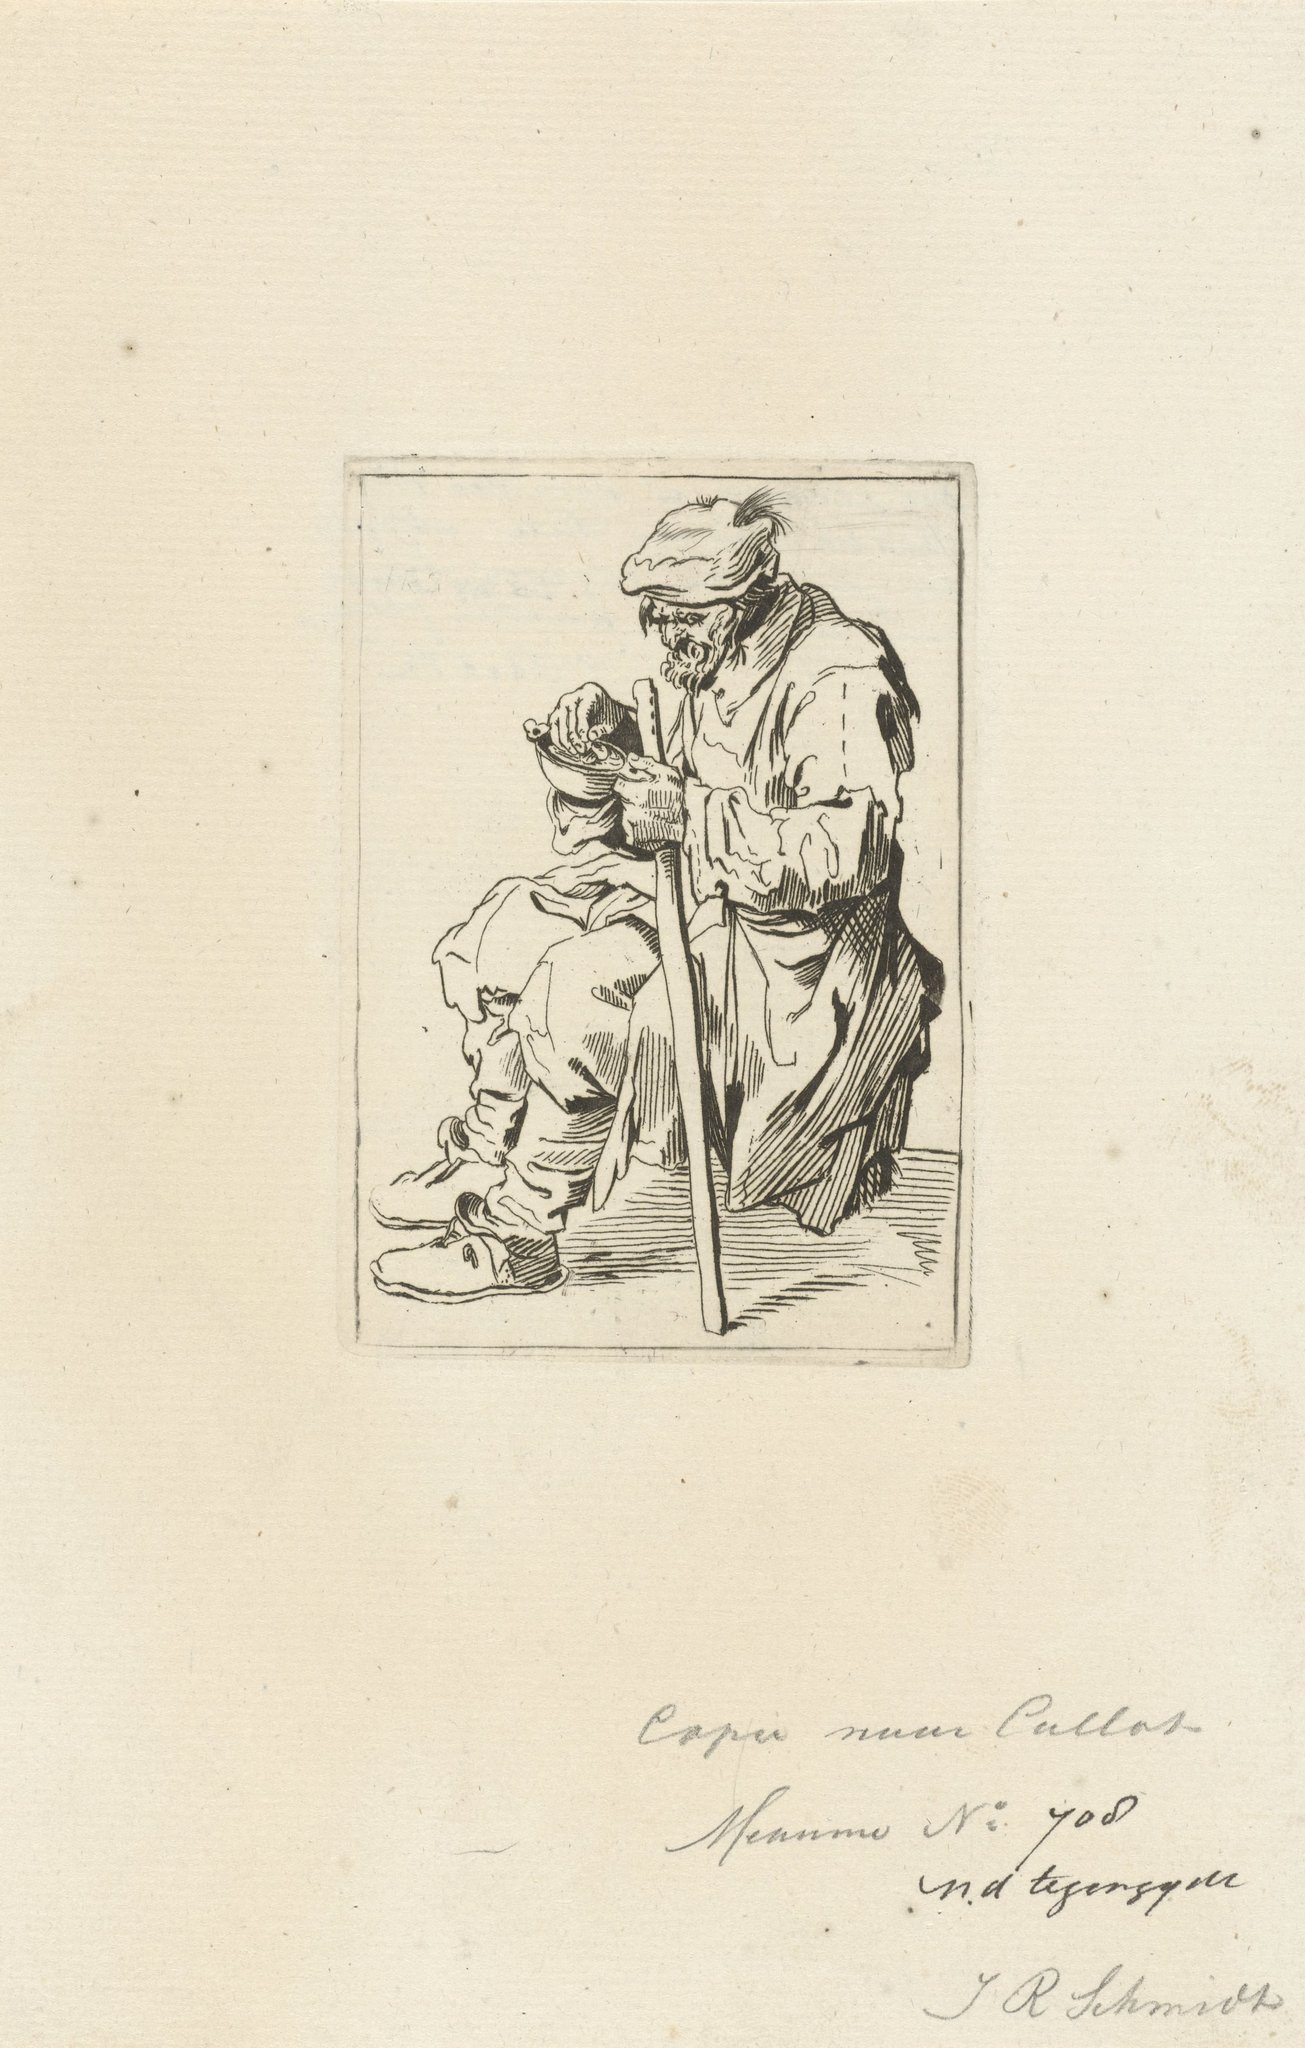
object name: print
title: Zittende bedelaar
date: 1791-1826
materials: paper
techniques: drypoint, etching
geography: netherlands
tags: beggar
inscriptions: inscription: ‘Copei naar Callot / Meaume N: 708 / vd tegenzyde / I R Smidt’, collector's mark: Lugt 2228, inscription: ‘Dit plaatje is door den Hr / Smidt aan der Heer Nagels / ten geschenken gegeven en vd hr Nagels/ door my op [...] auctie gekocht / J Ph vd K’